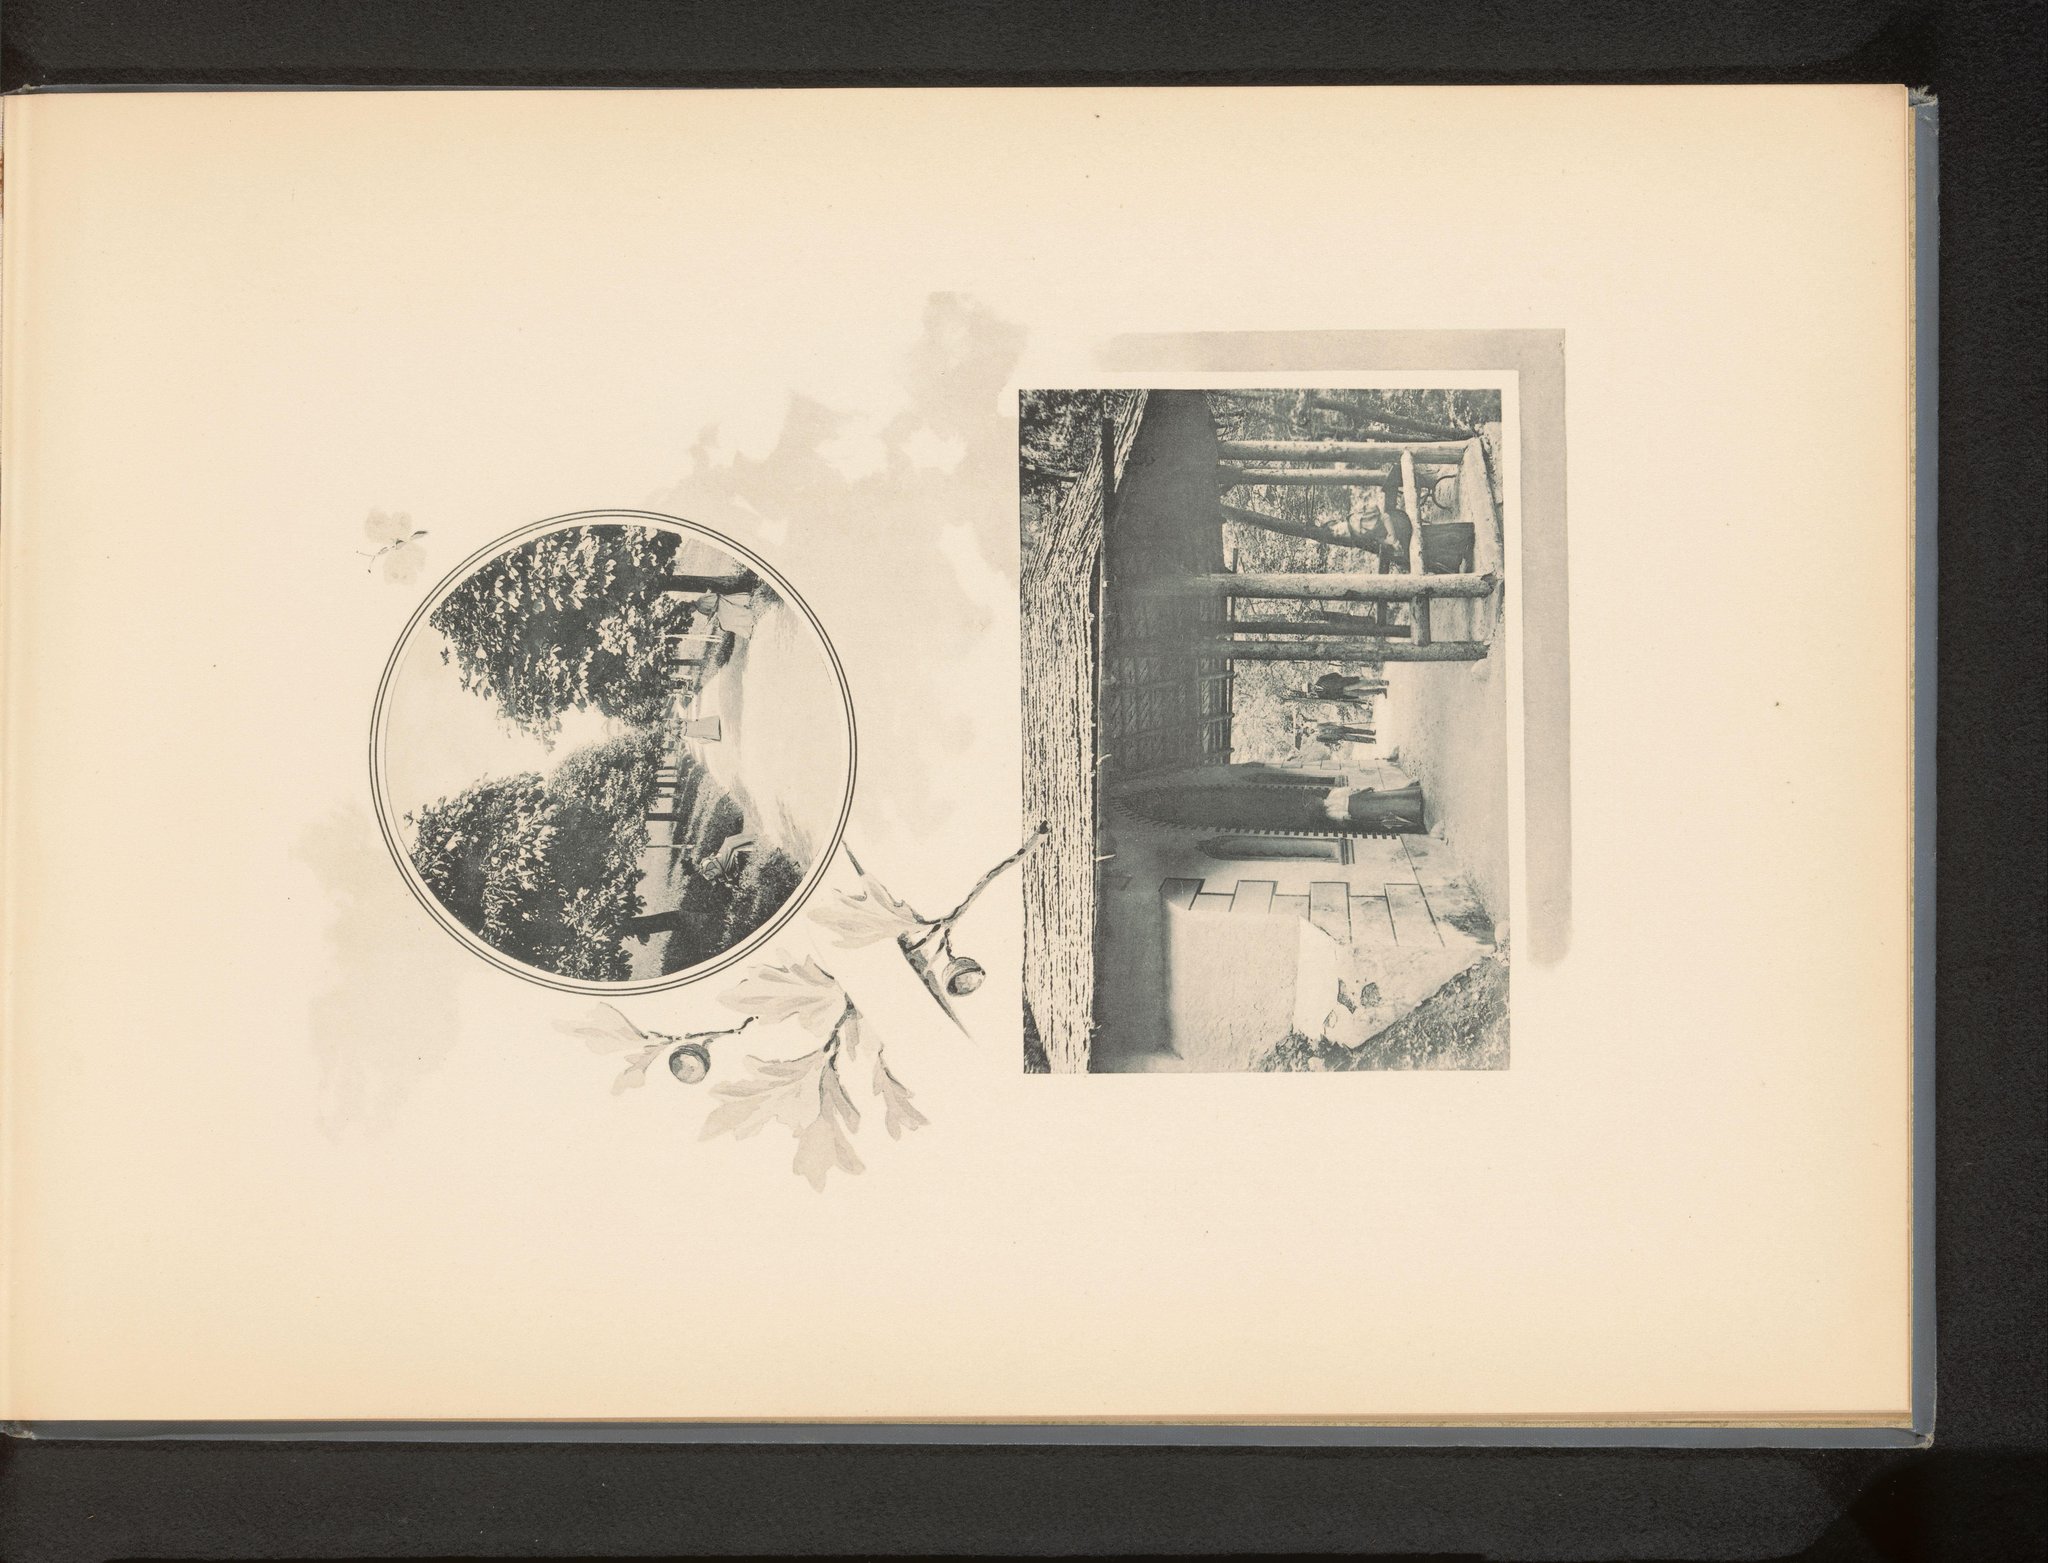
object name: photomechanical print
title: Twee afbeeldingen van wandelende gezelschappen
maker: Anonymous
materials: paper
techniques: photograph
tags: adult woman, walking, hiking (recreation), adult man, avenue, boulevard, promenade, esplanade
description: Boven twee vrouwen op bankjes aan weerszijden van een promenade waarop een derde vrouw loopt. Onder twee heren en twee dames tijdens een wandeling.